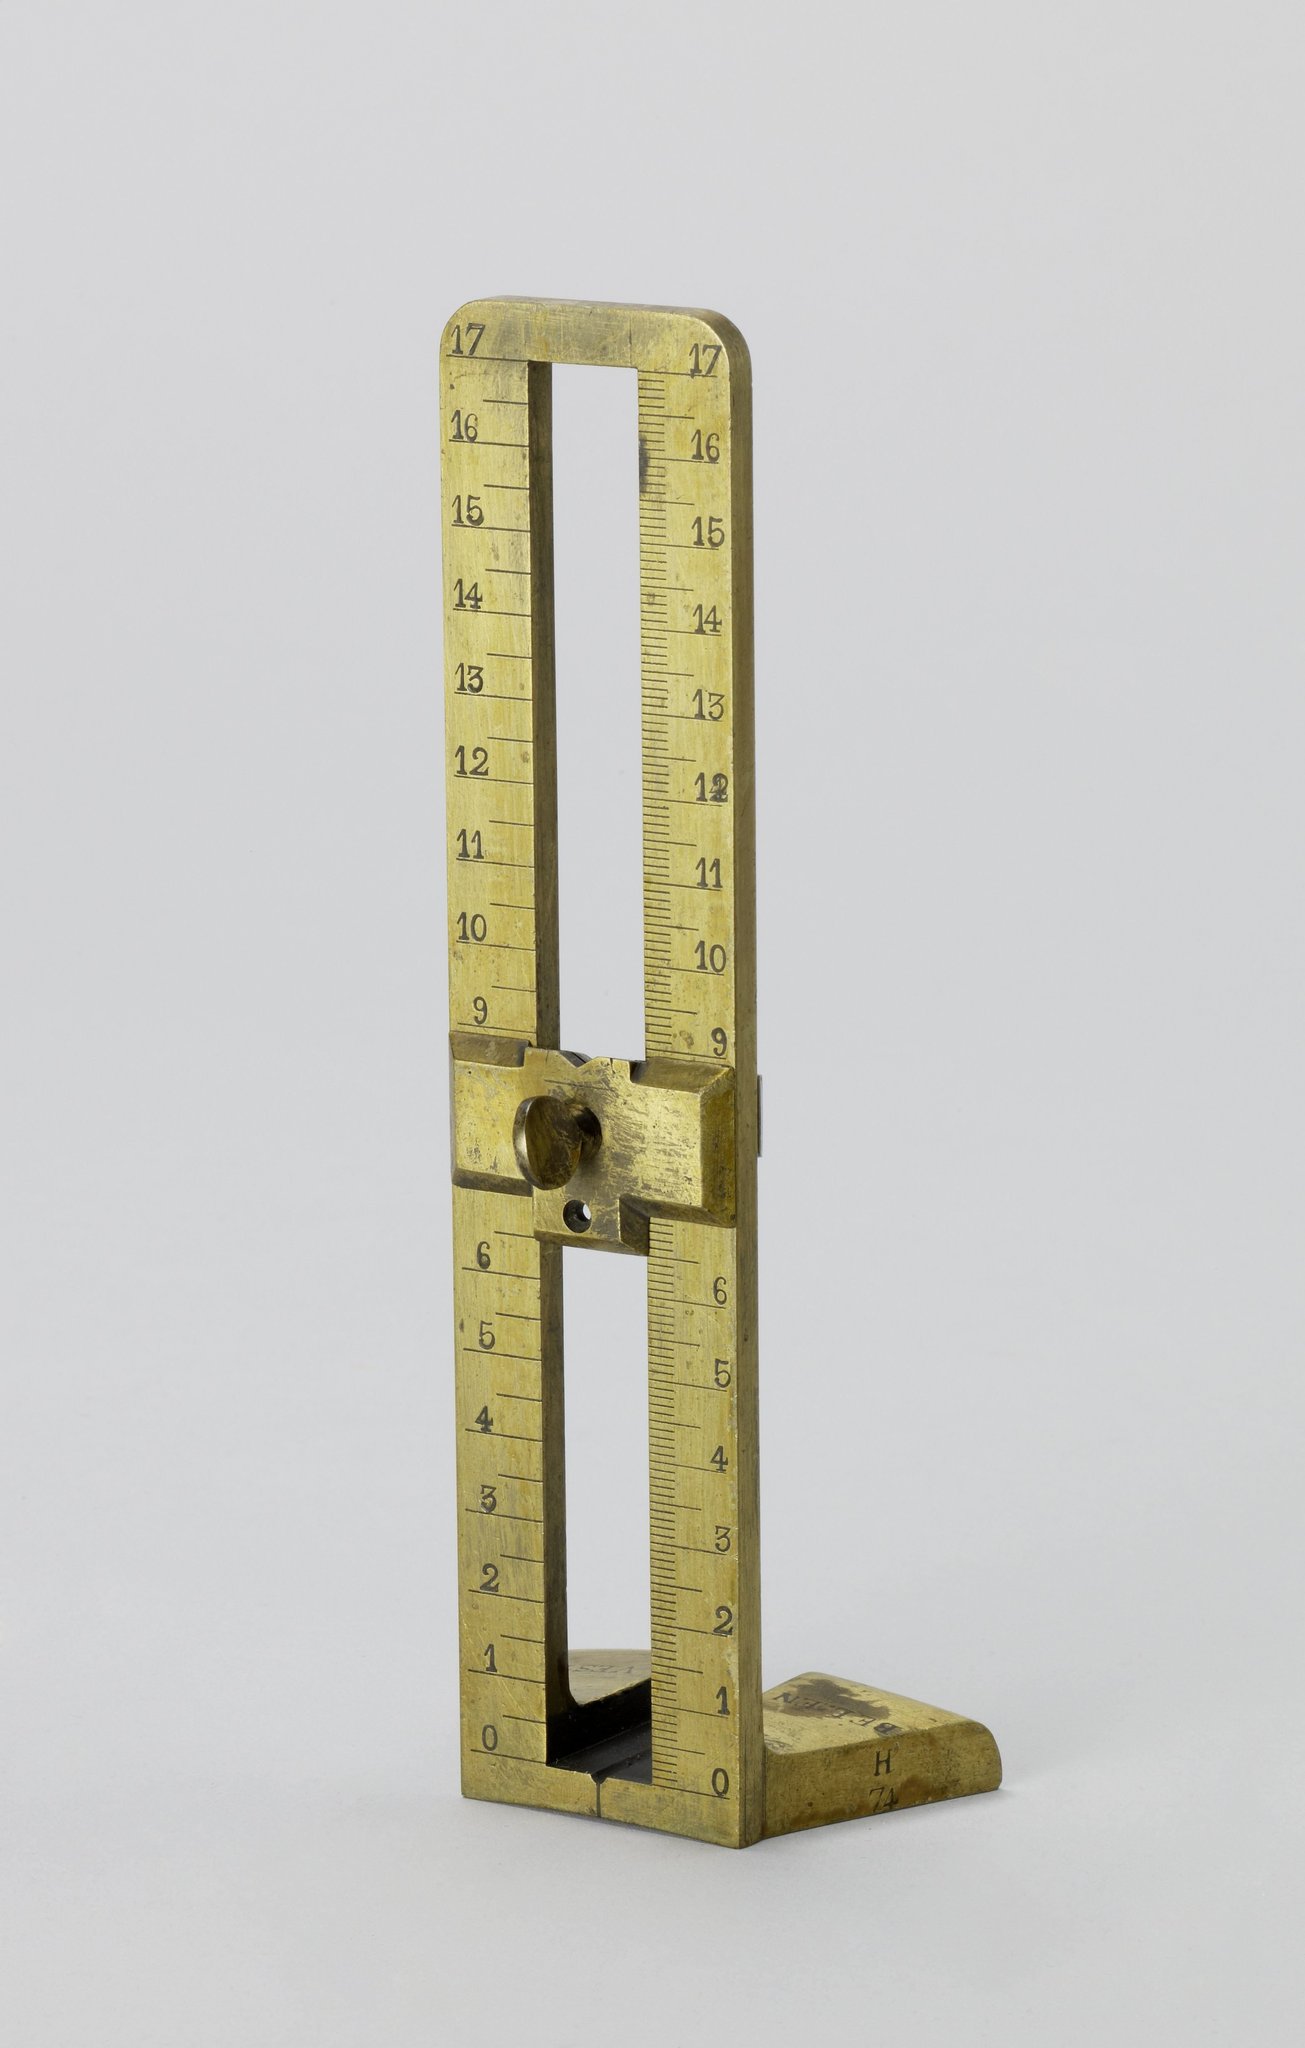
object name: demonstration model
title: Gun Sight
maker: Anonymous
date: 1860-1870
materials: brass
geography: netherlands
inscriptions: inscription, on the base: ‘BEL. EN VEST.’, inscription, on the side: ‘H / 74’, inscription, opposite: ‘G / vL’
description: Messing opzet of vizier, bestaande uit twee verticale stangen waartussen een vizier op en neer schuift. Aan een kant hebben de stangen een schaal gaande van 0 tot 17. Het vizier heeft een trapezevormige voet, die met een kernring bij de halsband op de loop werd gebonden.